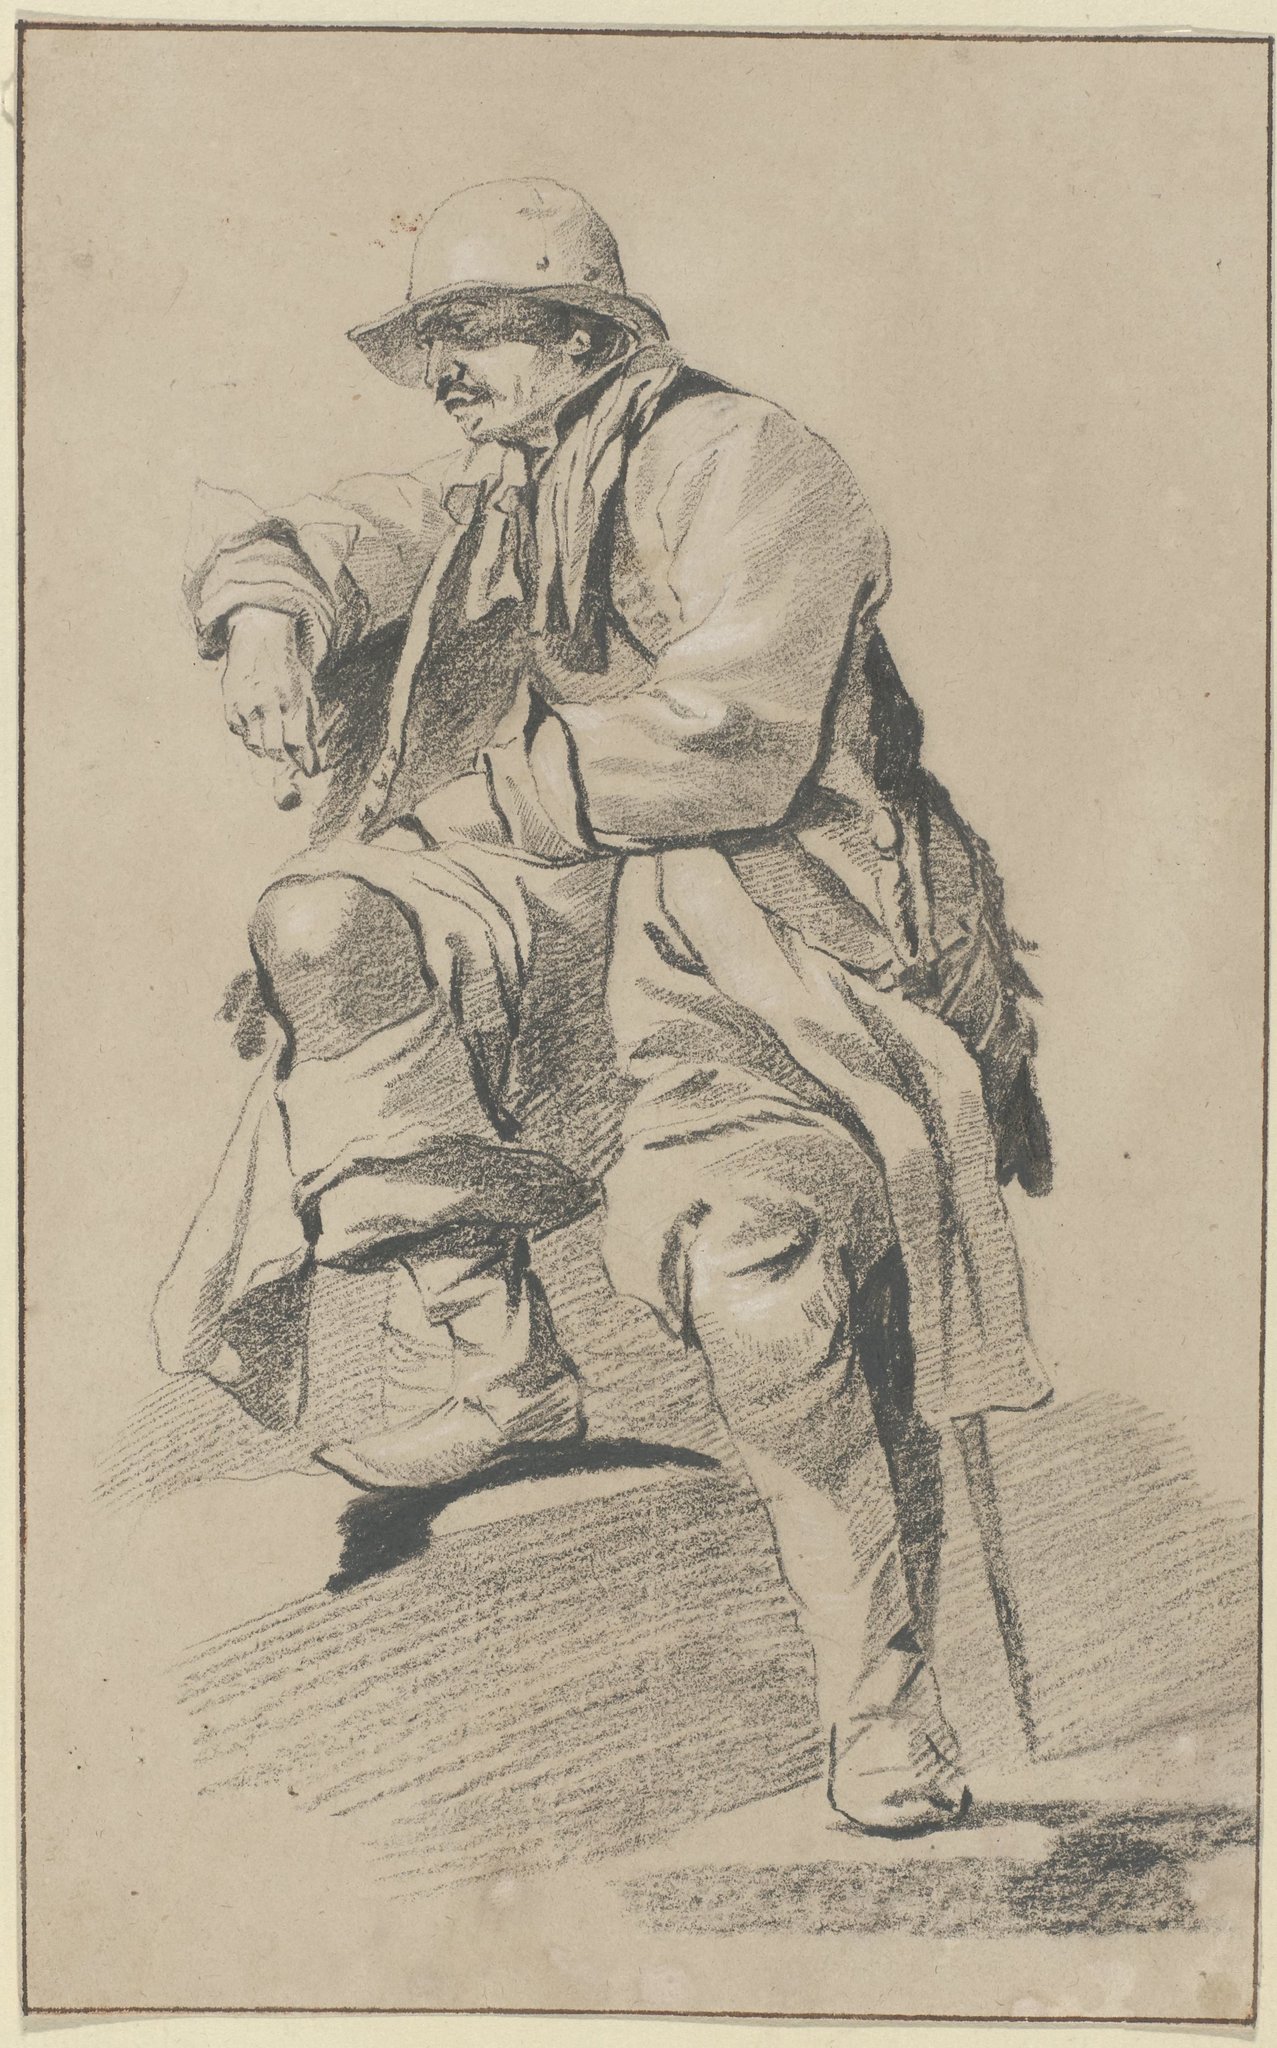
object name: drawing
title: Zittende man, naar links gewend, met hoed, snor, sabel en pijp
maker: cornelis pietersz. bega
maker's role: draughtsman, painter, print maker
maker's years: 1631-1664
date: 1650-1675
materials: chalk, paper